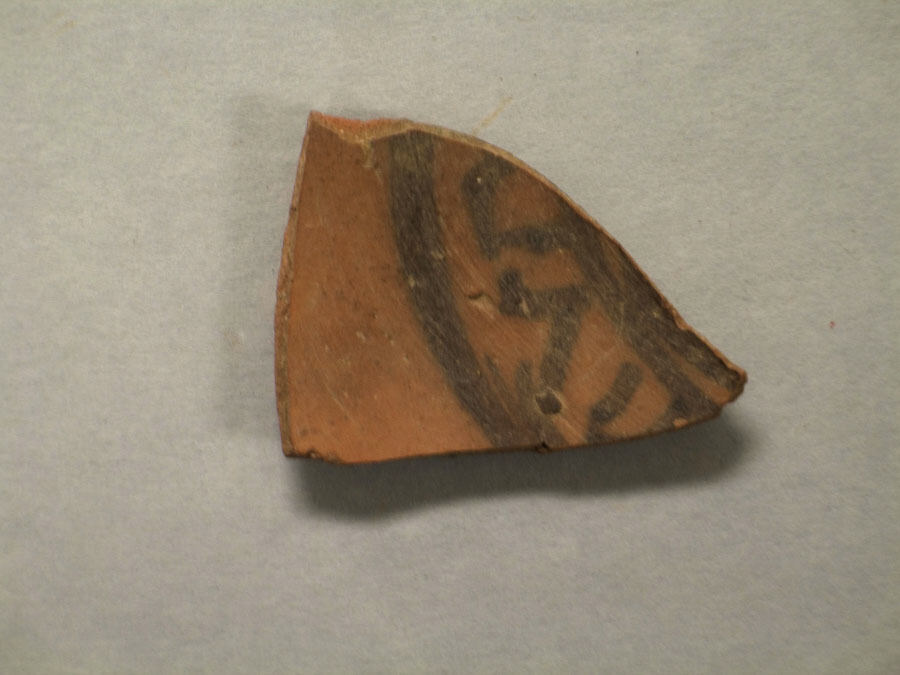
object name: shard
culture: pakistani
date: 301-500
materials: terracotta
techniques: painting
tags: gandhara